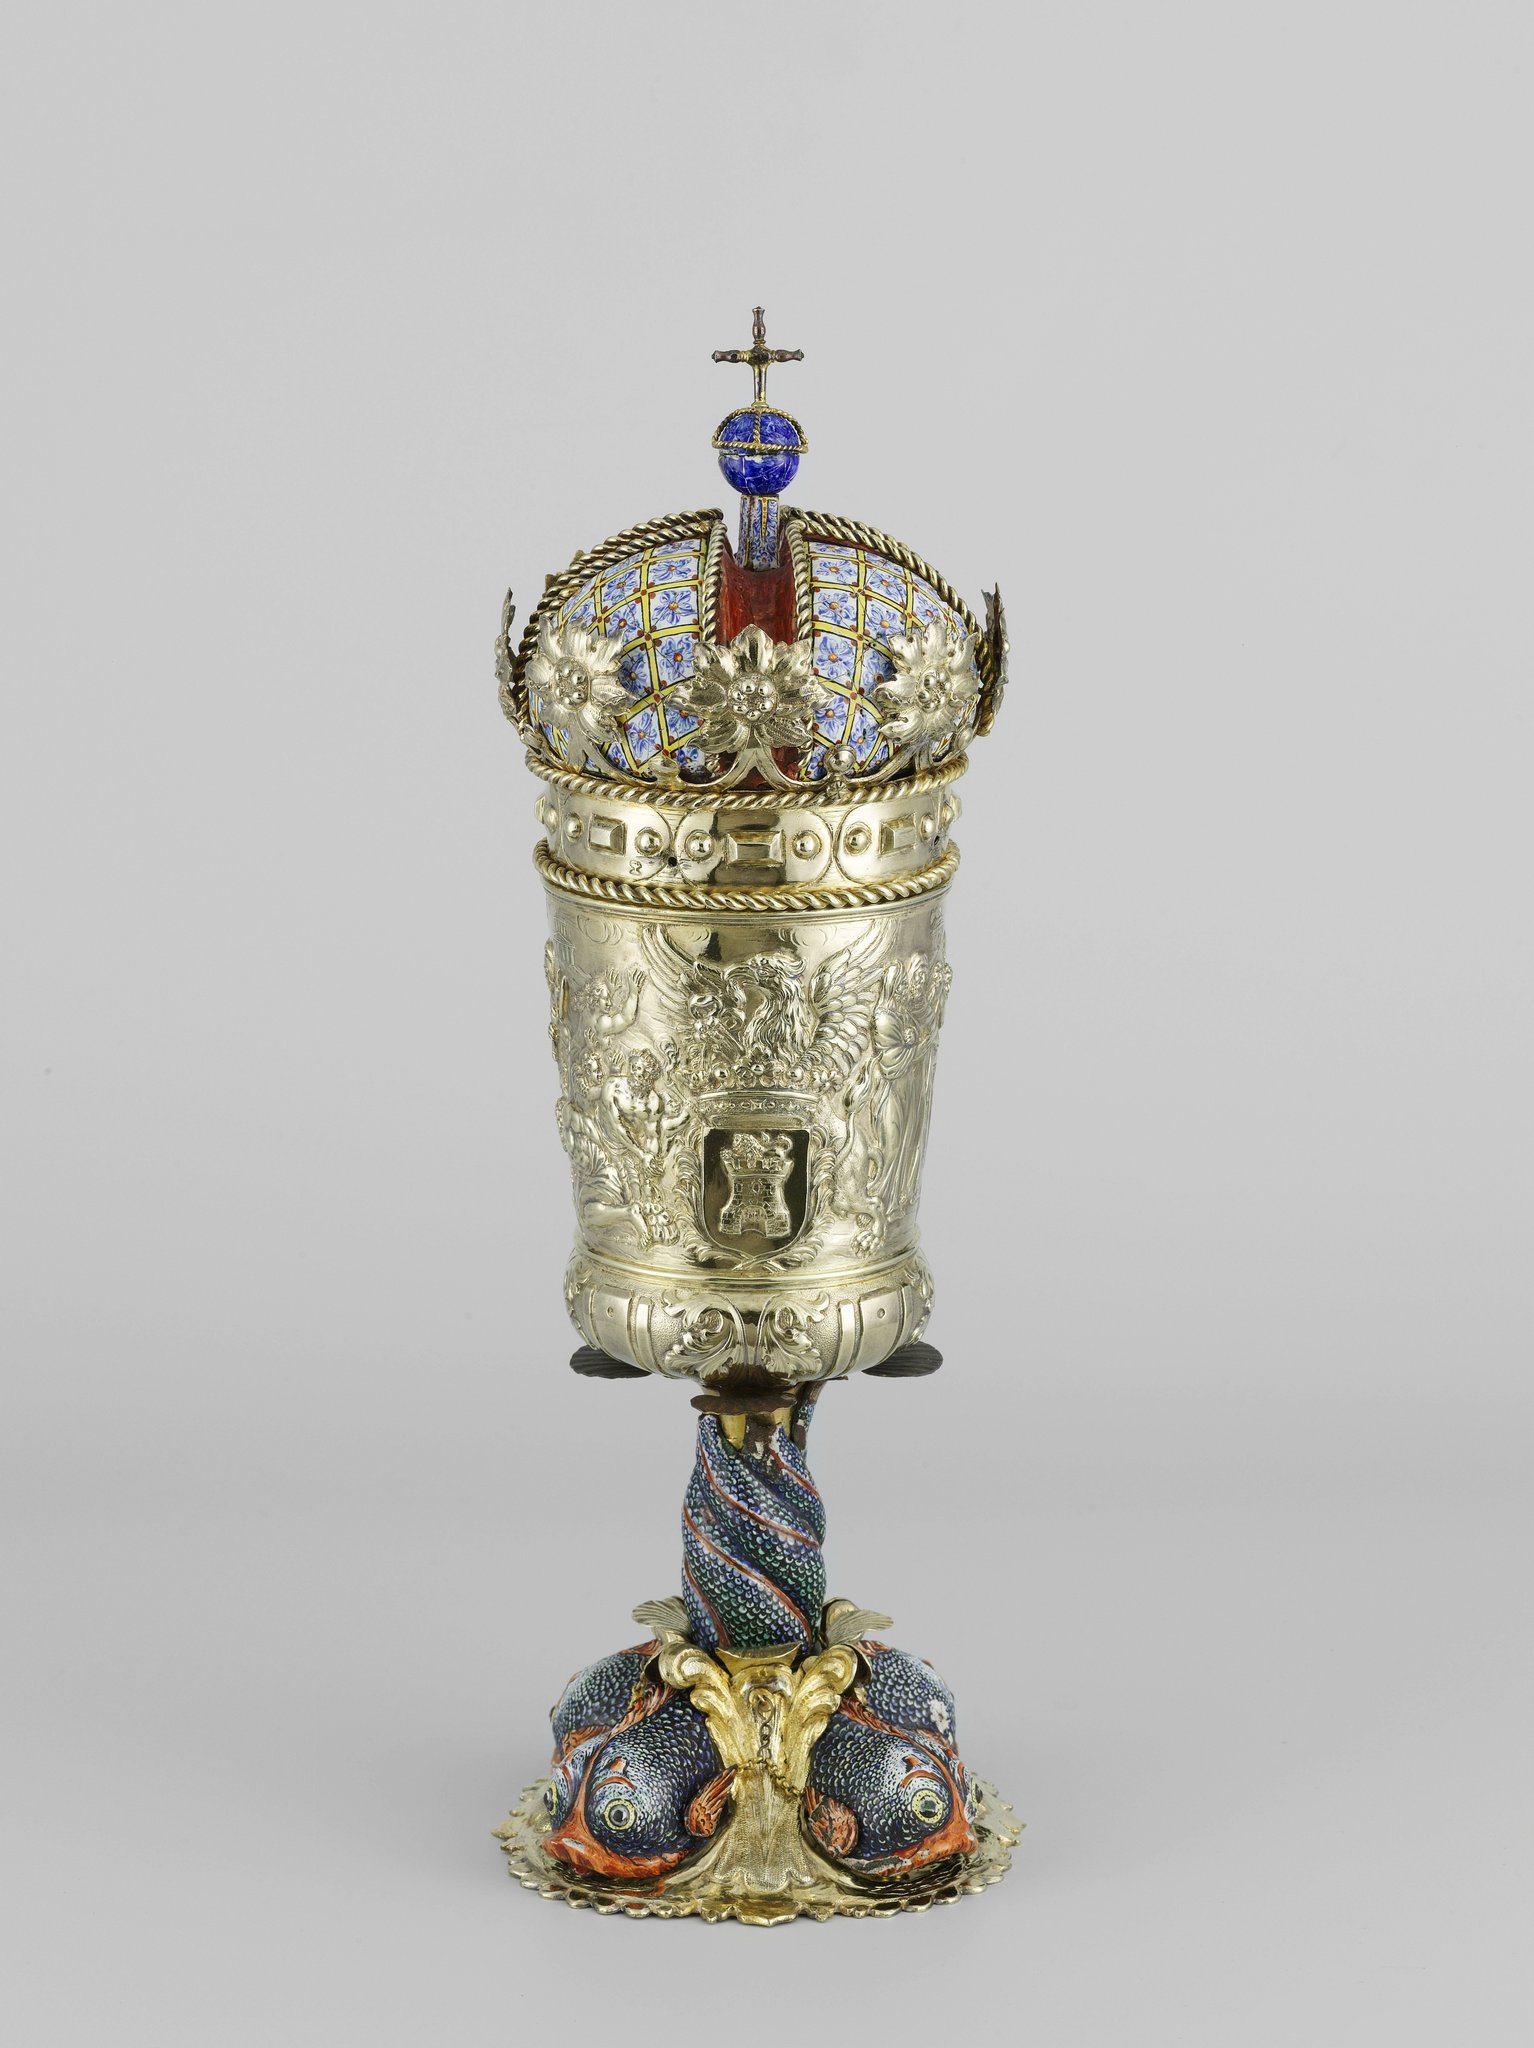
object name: cup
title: Cup of the Court of Justice of Voorne and Putten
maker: Anonymous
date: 1701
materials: copper, silver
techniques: gilding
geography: haarlem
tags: dolphin ~ ornament, orb (symbol of sovereignty; sphere with cross on top)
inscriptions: date letter: ‘P’, town mark, maker's mark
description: The warden of Voorne and Putten organized an annual dinner for the officials with whom he would adjudicate that year. At this event they all drank from this cup, affirming that they would review the disputes brought before them in concert and without prejudice. The cup is superbly worked with chasing and enamel. The fish on the base of the cup – rock bass, or ‘voorns’ in Dutch – refer to the city of Voorne.